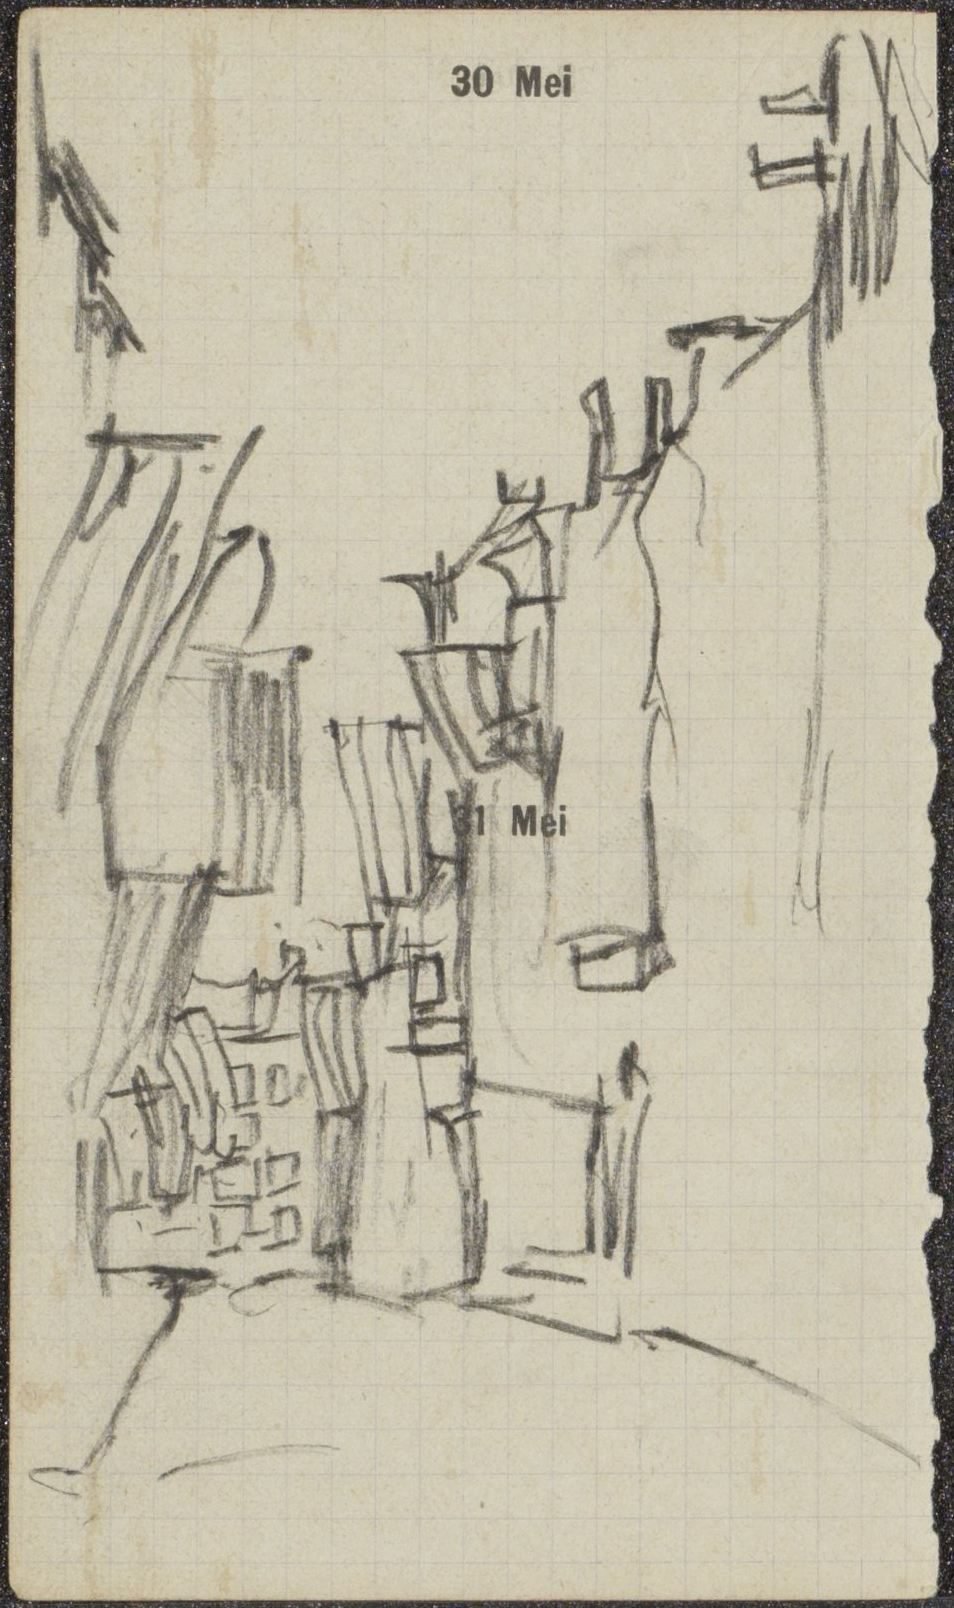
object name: drawing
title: Gezicht op de Hartenstraat in Amsterdam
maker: george hendrik breitner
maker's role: draughtsman, painter, print maker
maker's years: 1857-1923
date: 1886-1923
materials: chalk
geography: amsterdam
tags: street, flag, colours (as symbol of the state, etc.)